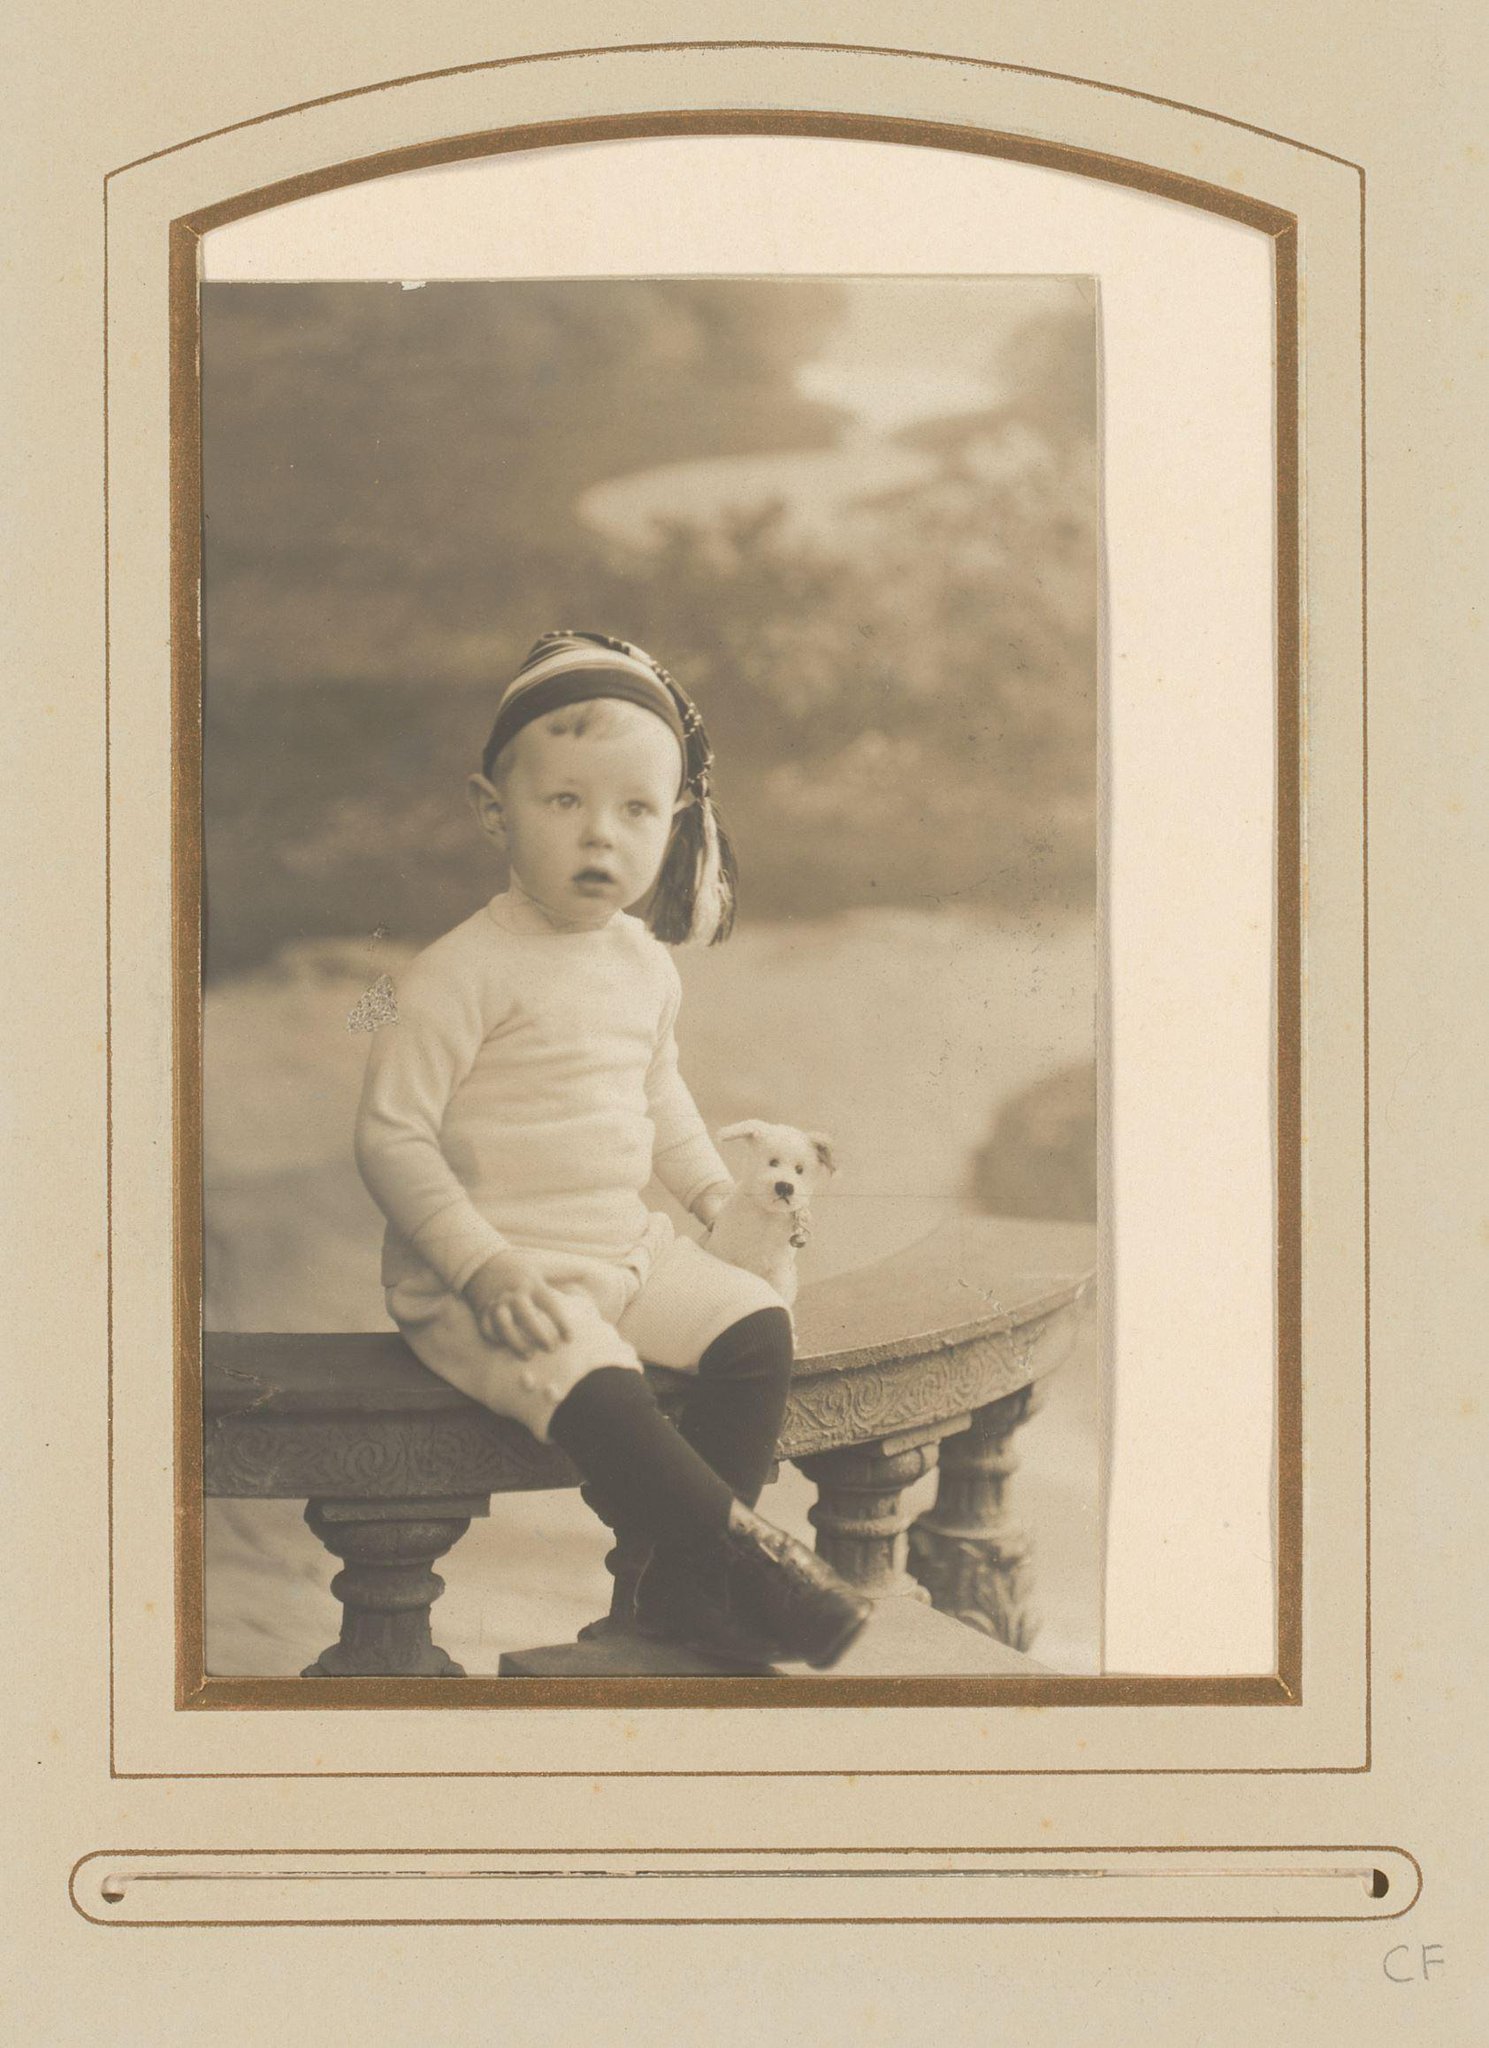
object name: album leaf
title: Portret van Johannes Tromp met een speelgoed hond, zittend op een balustrade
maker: Anonymous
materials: cardboard, photographic support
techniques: collodion silver print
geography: netherlands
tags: (playing with) toy animals, historical persons, toddler (male), balustrade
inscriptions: inscription: ‘16 augs 1912./ Lieve Mijnheer en/ Mevrouw,/ Hier ben ik met/ mijn hondje. Nu/ ben ik er niet meer/ zóó bang voor./ Johannes Tromp/ Emmastr. 19./ Wel Ed Geb Heer N. de Lnage/ Controleur Buitengew Zegel/ Amsterdam/ v. Breestraat.’